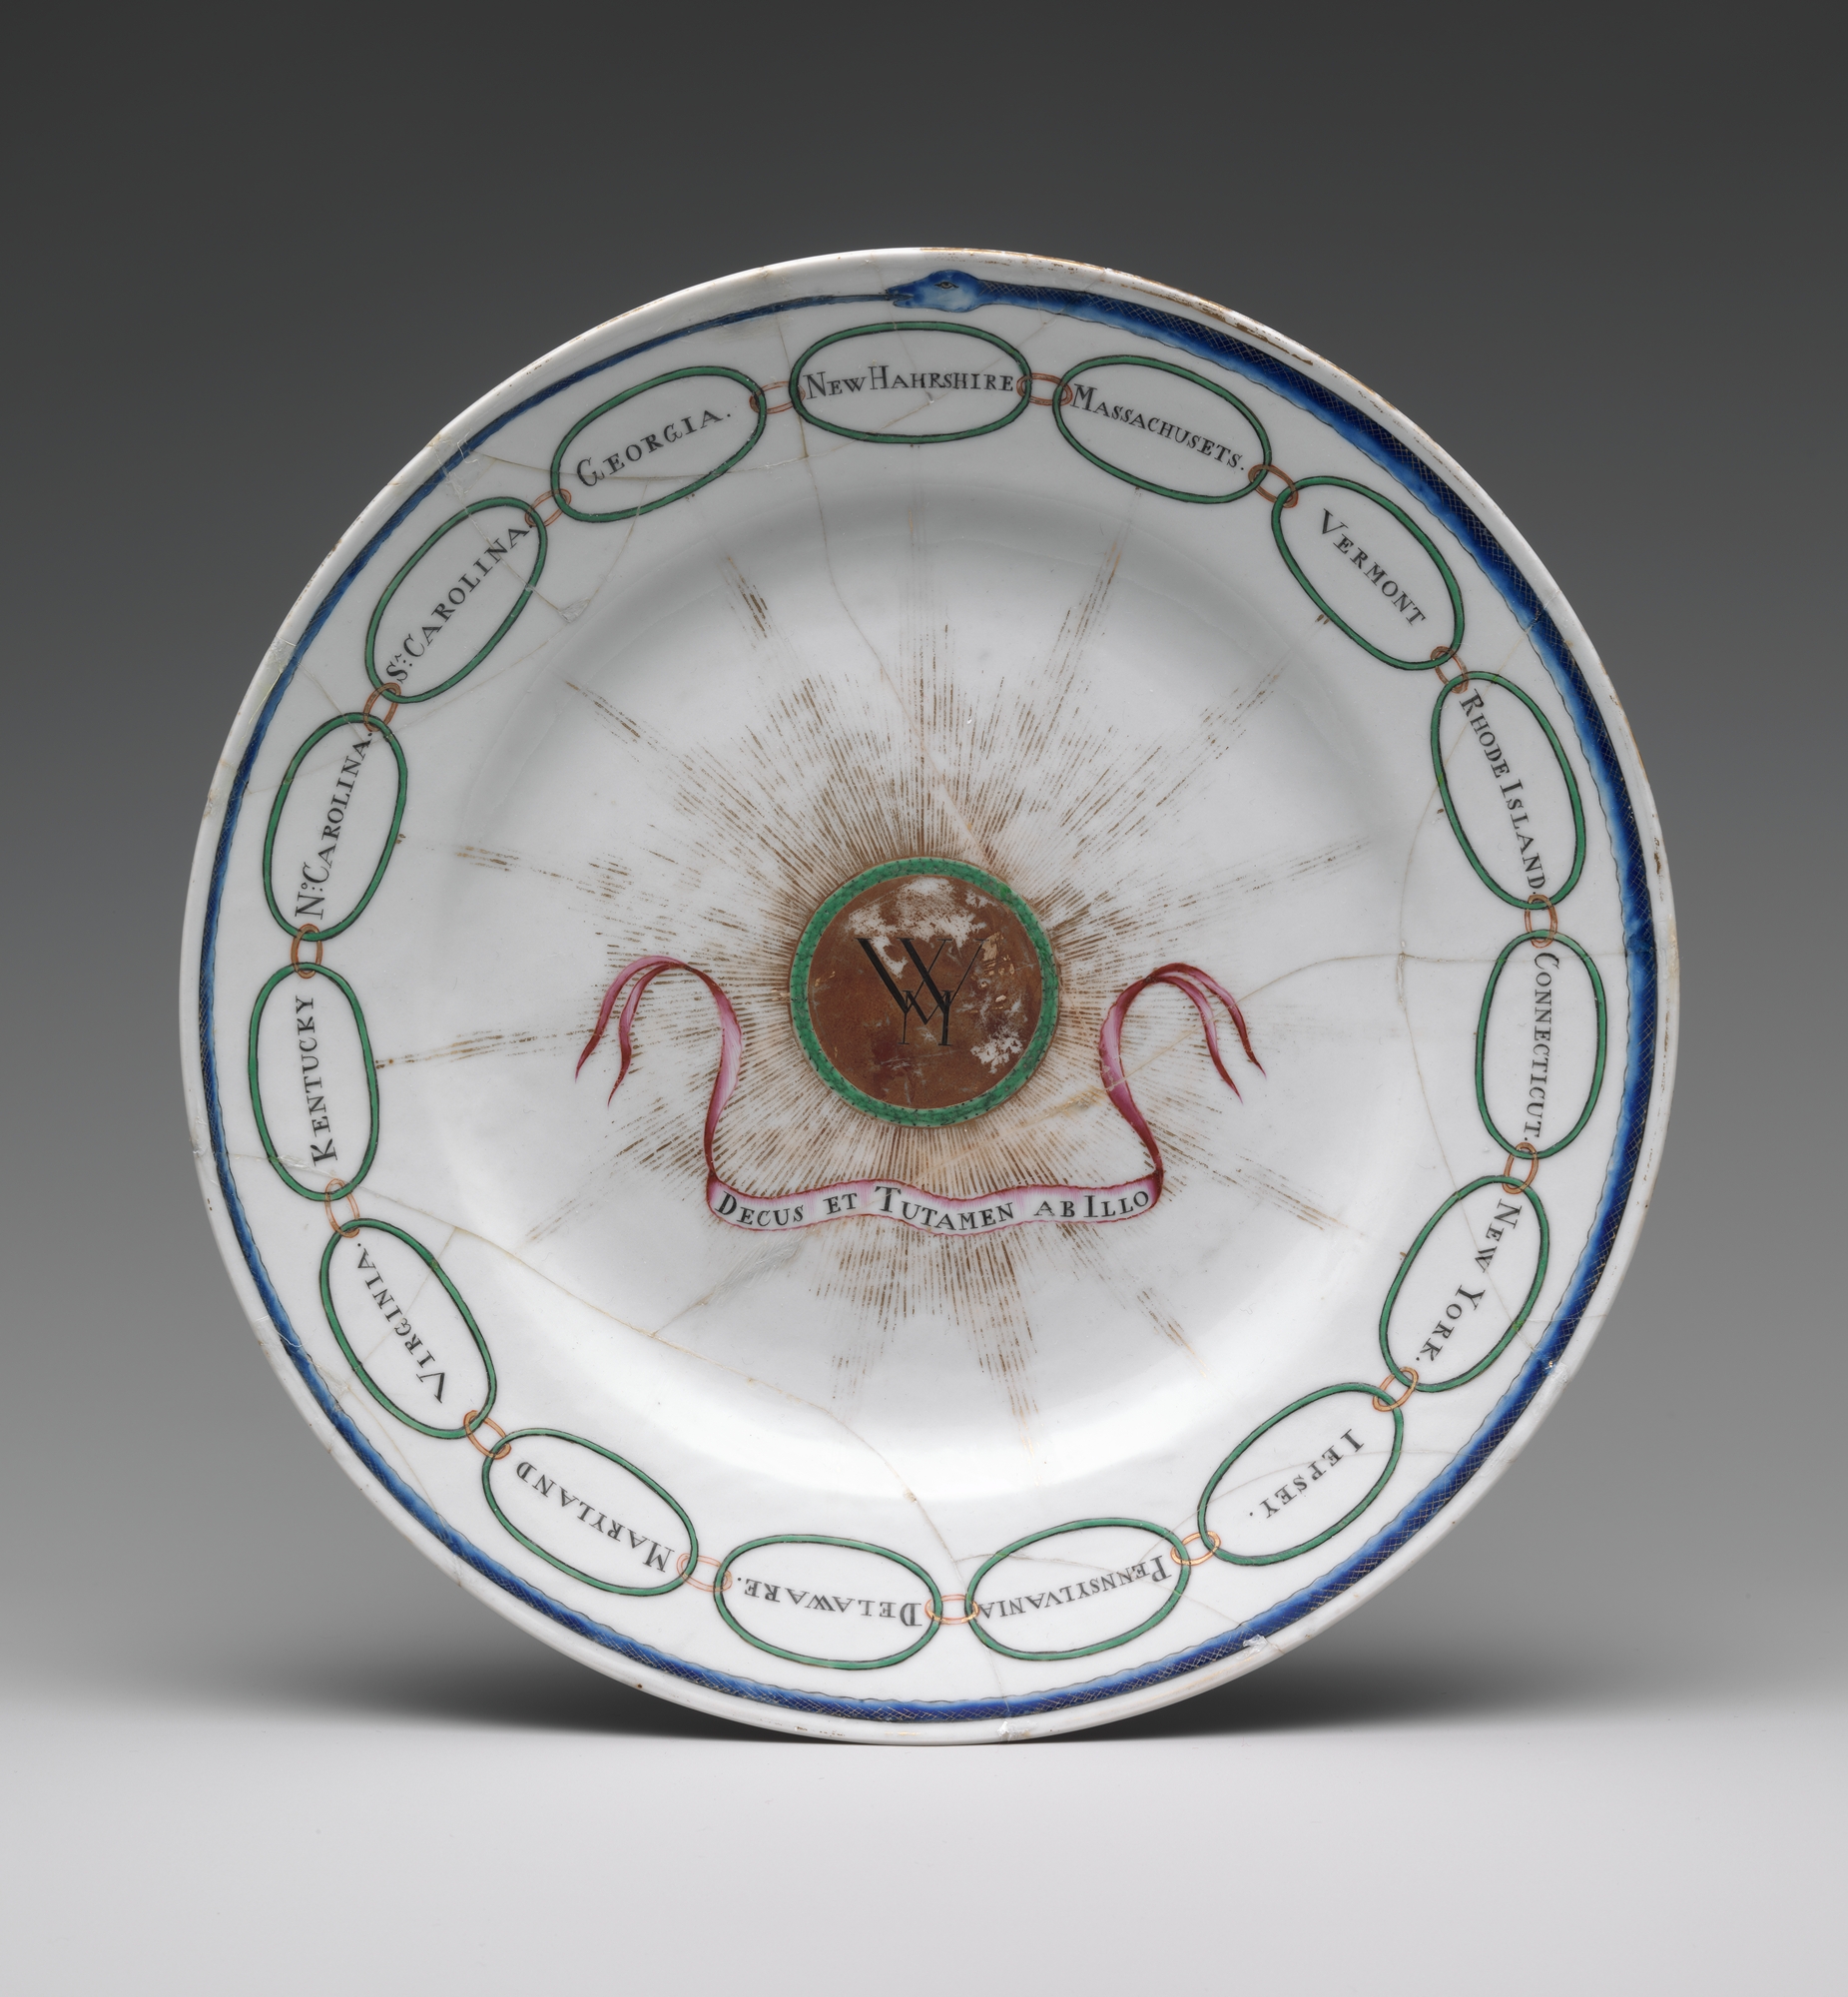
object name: plate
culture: chinese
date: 1795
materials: porcelain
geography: china